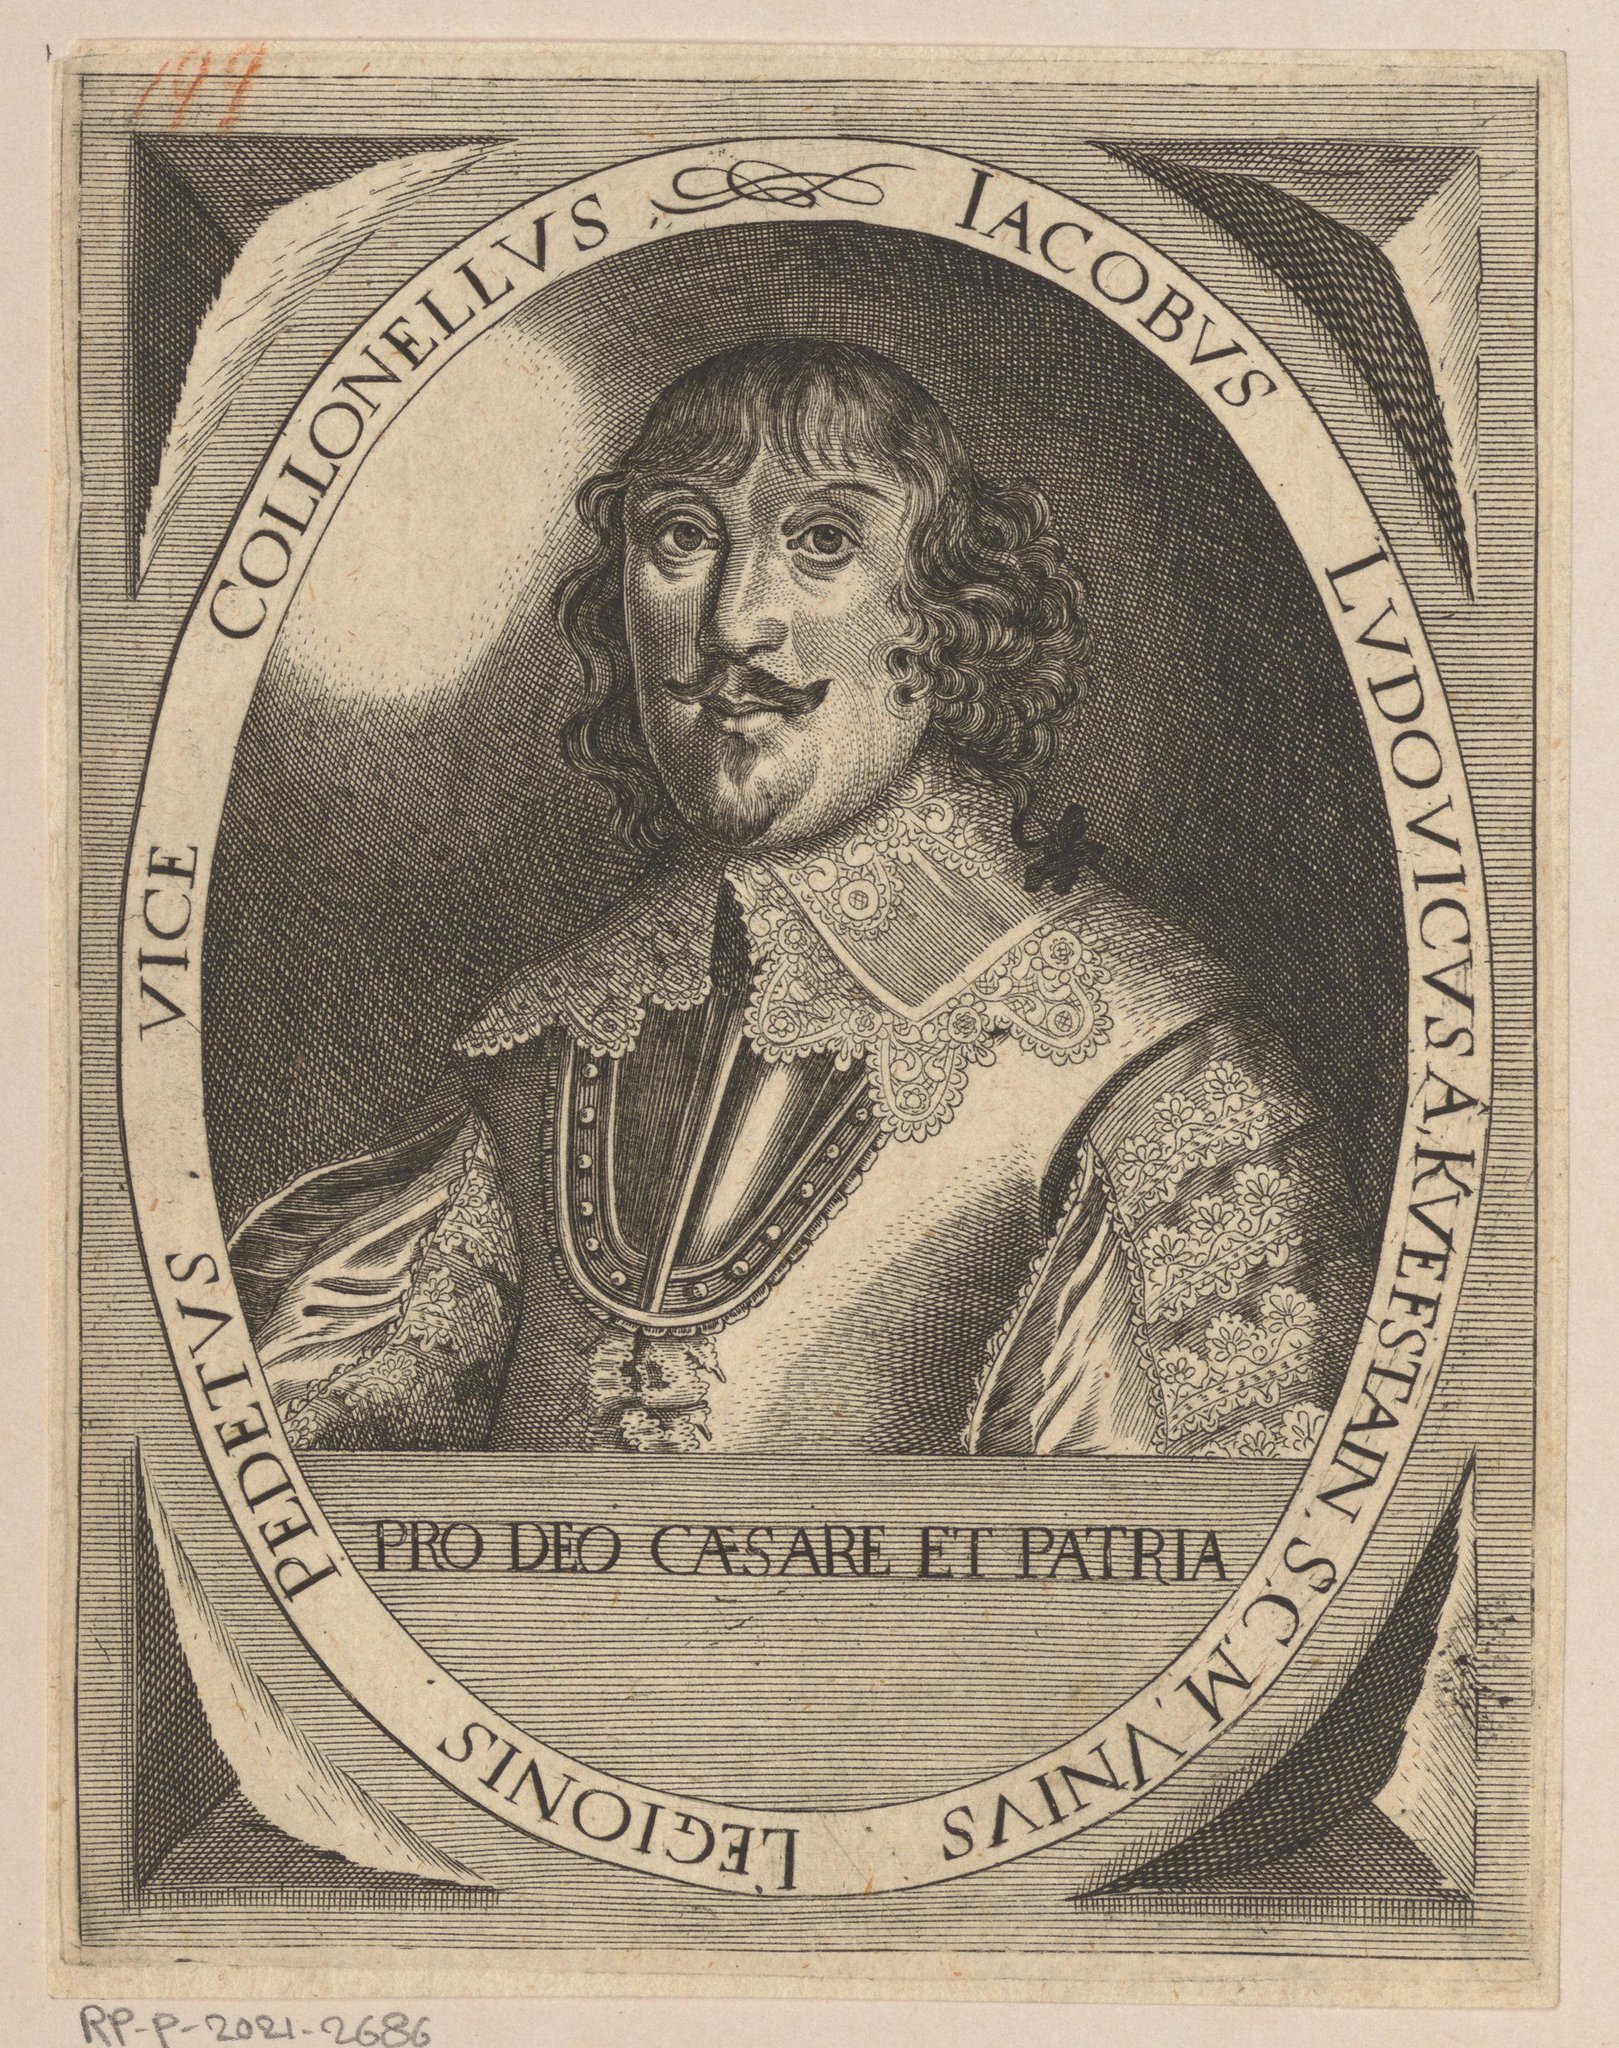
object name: print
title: Portret van Johann Ludwig von Kuefstein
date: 1646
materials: paper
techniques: engraving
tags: historical persons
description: Andere staat gebruikt in: Widemann, Elias. Comitium gloriae centum qua sanguine qua virtute illustrium heroum. Wenen: s.n., 1646.